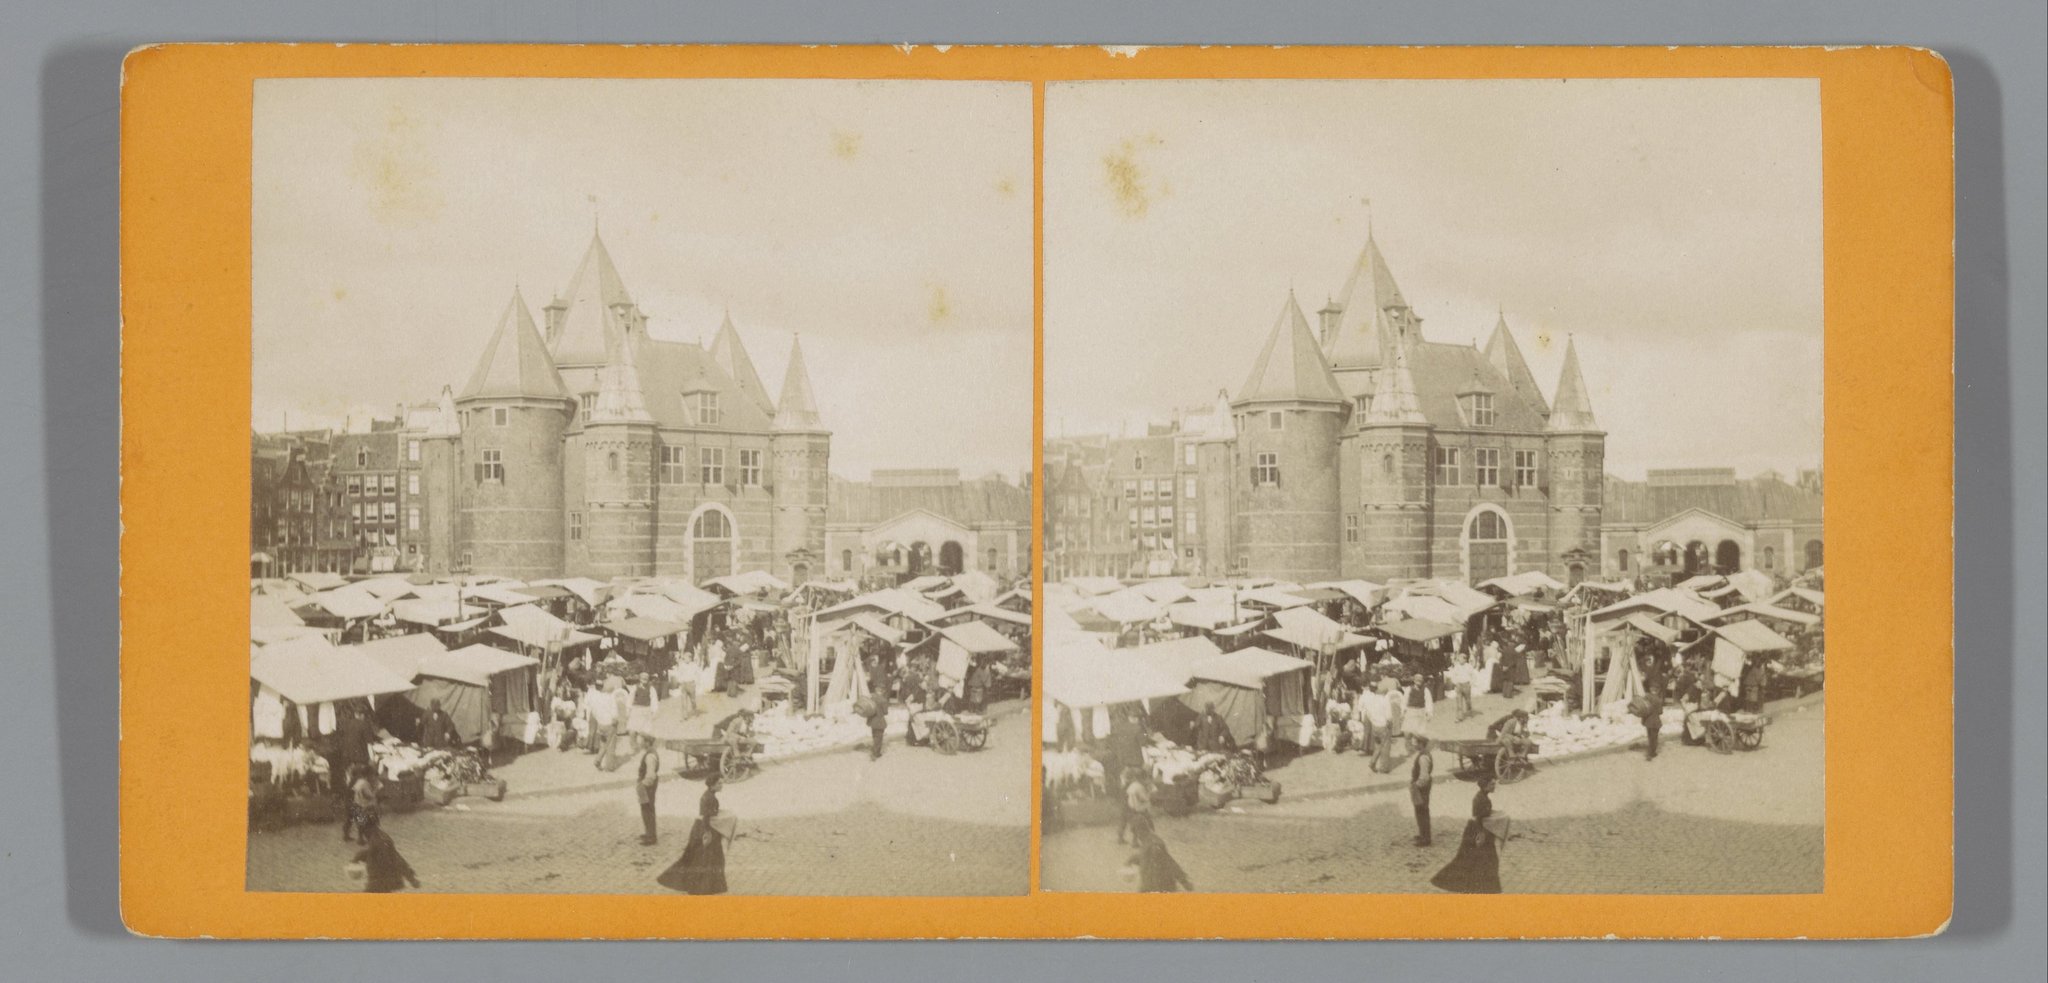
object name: stereograph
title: Markt op de Nieuwmarkt rond de Waag, Amsterdam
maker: Anonymous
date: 1868-1890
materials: cardboard, paper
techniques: albumen print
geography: amsterdam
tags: square, place, circus, etc., stall, booth (~ market), market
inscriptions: number: ‘4’